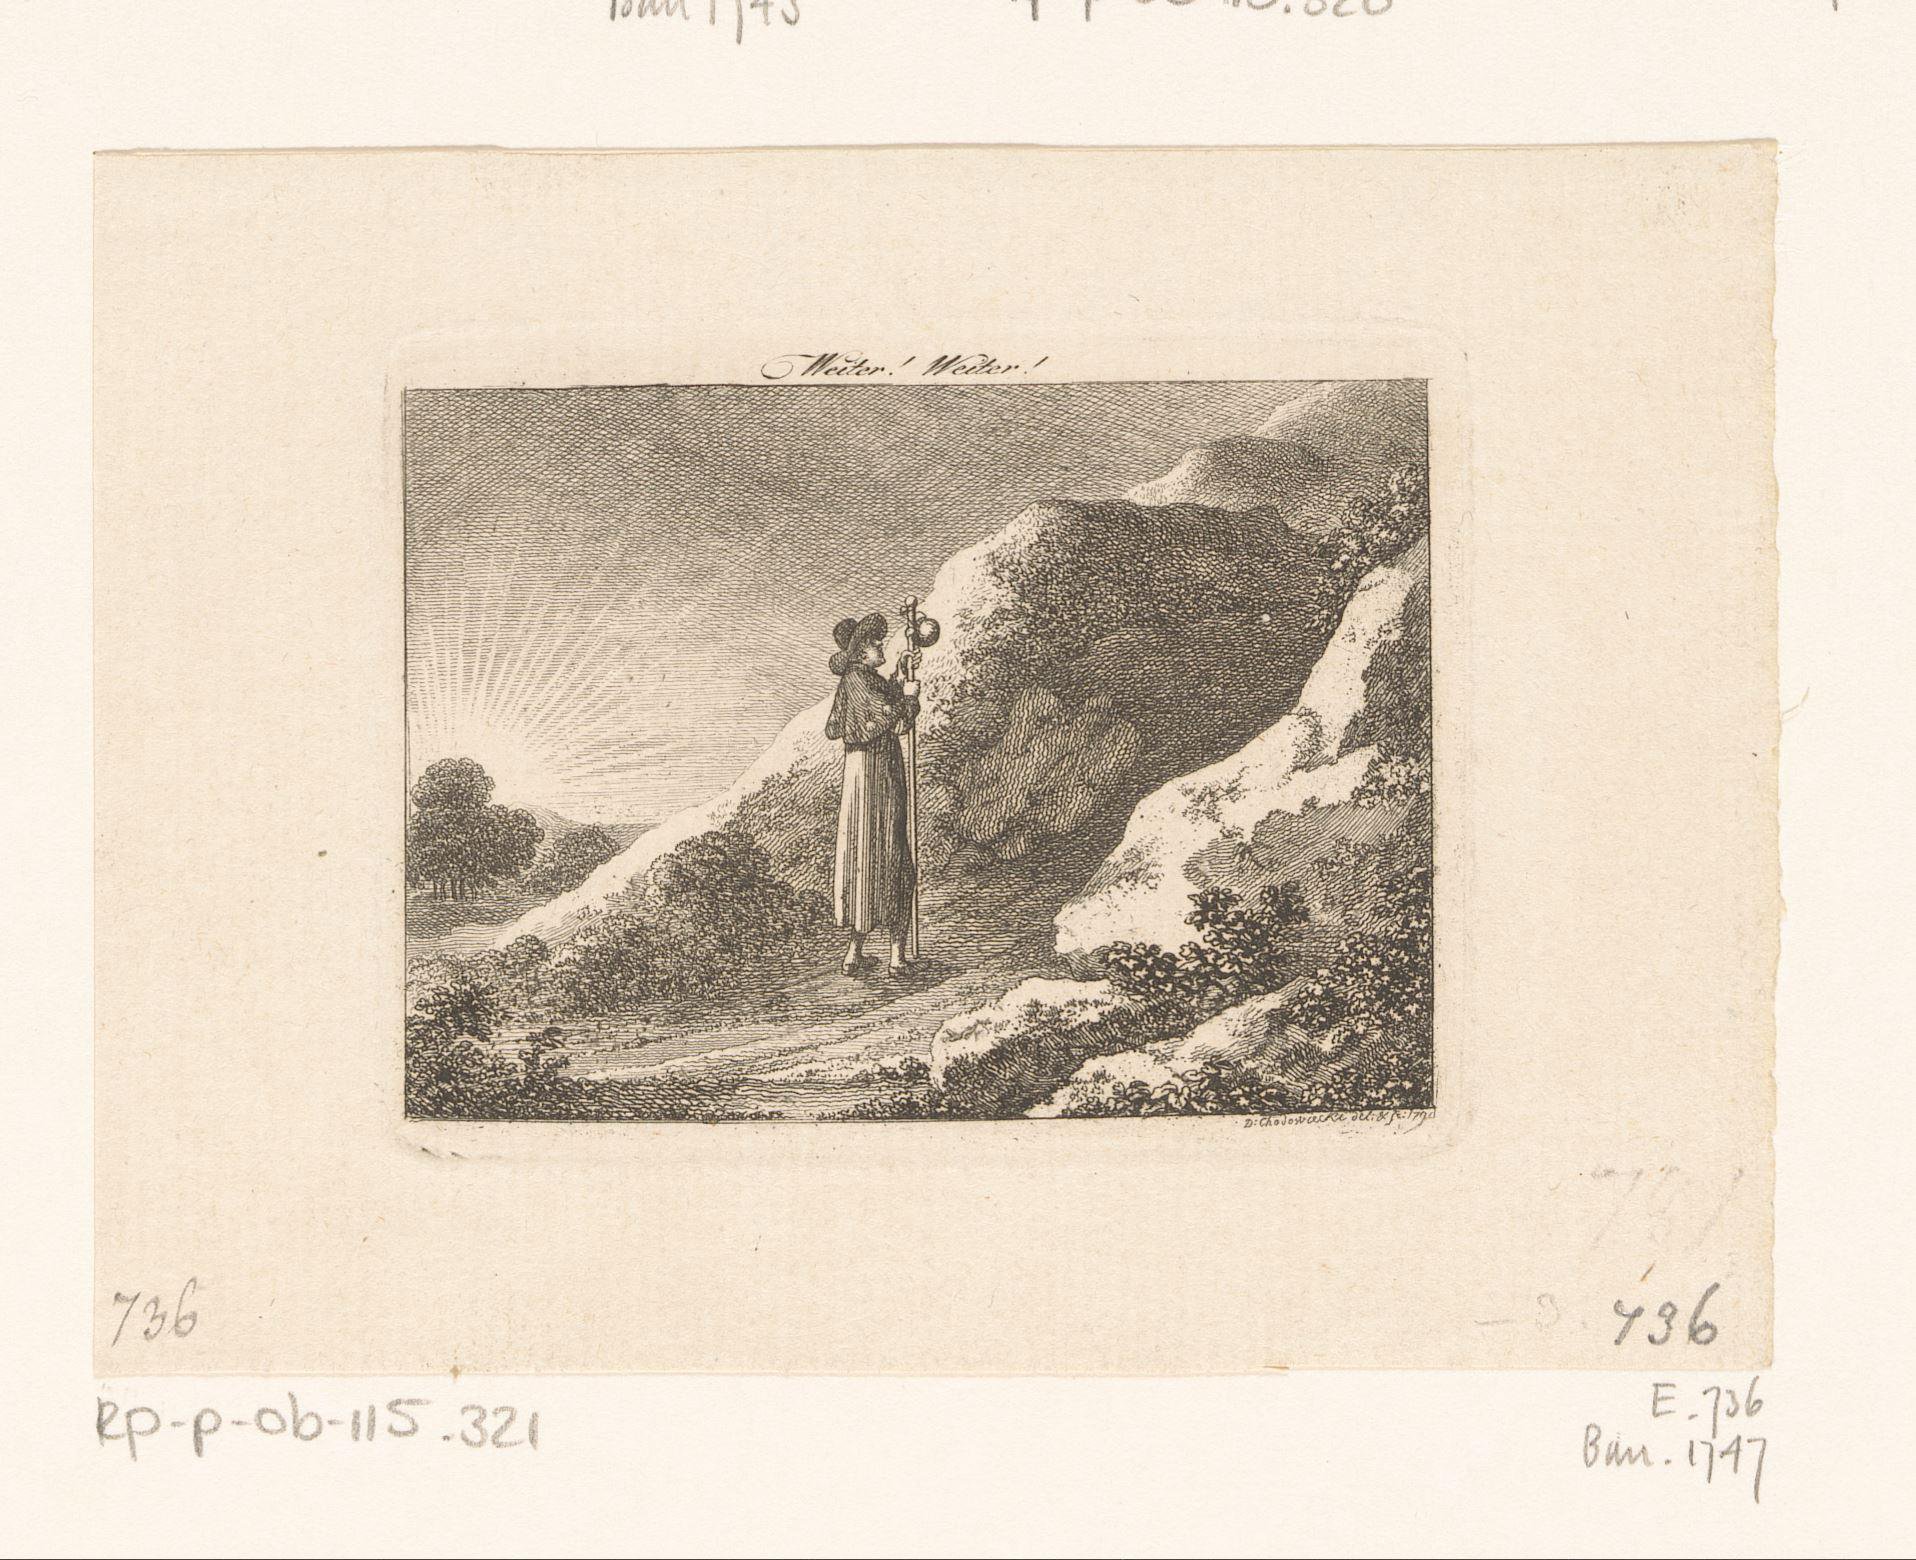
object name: print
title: Pelgrim betreedt de bergweg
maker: daniel nikolaus chodowiecki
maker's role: draughtsman, print maker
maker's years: 1726-1801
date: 1794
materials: paper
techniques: etching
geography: berlin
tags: pilgrim(s), sunrise, mountains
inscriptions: collector's mark: Lugt 2228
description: Prent gebruikt voor: Kinderling, Johann Friedrich August. Für deutsche Sprache Litteratur und Cultur-Geschichte. Eine Schrift der deutschen Gesellschaft zu Berlin (...). Berlijn: Gottfried Nauck, 1794.